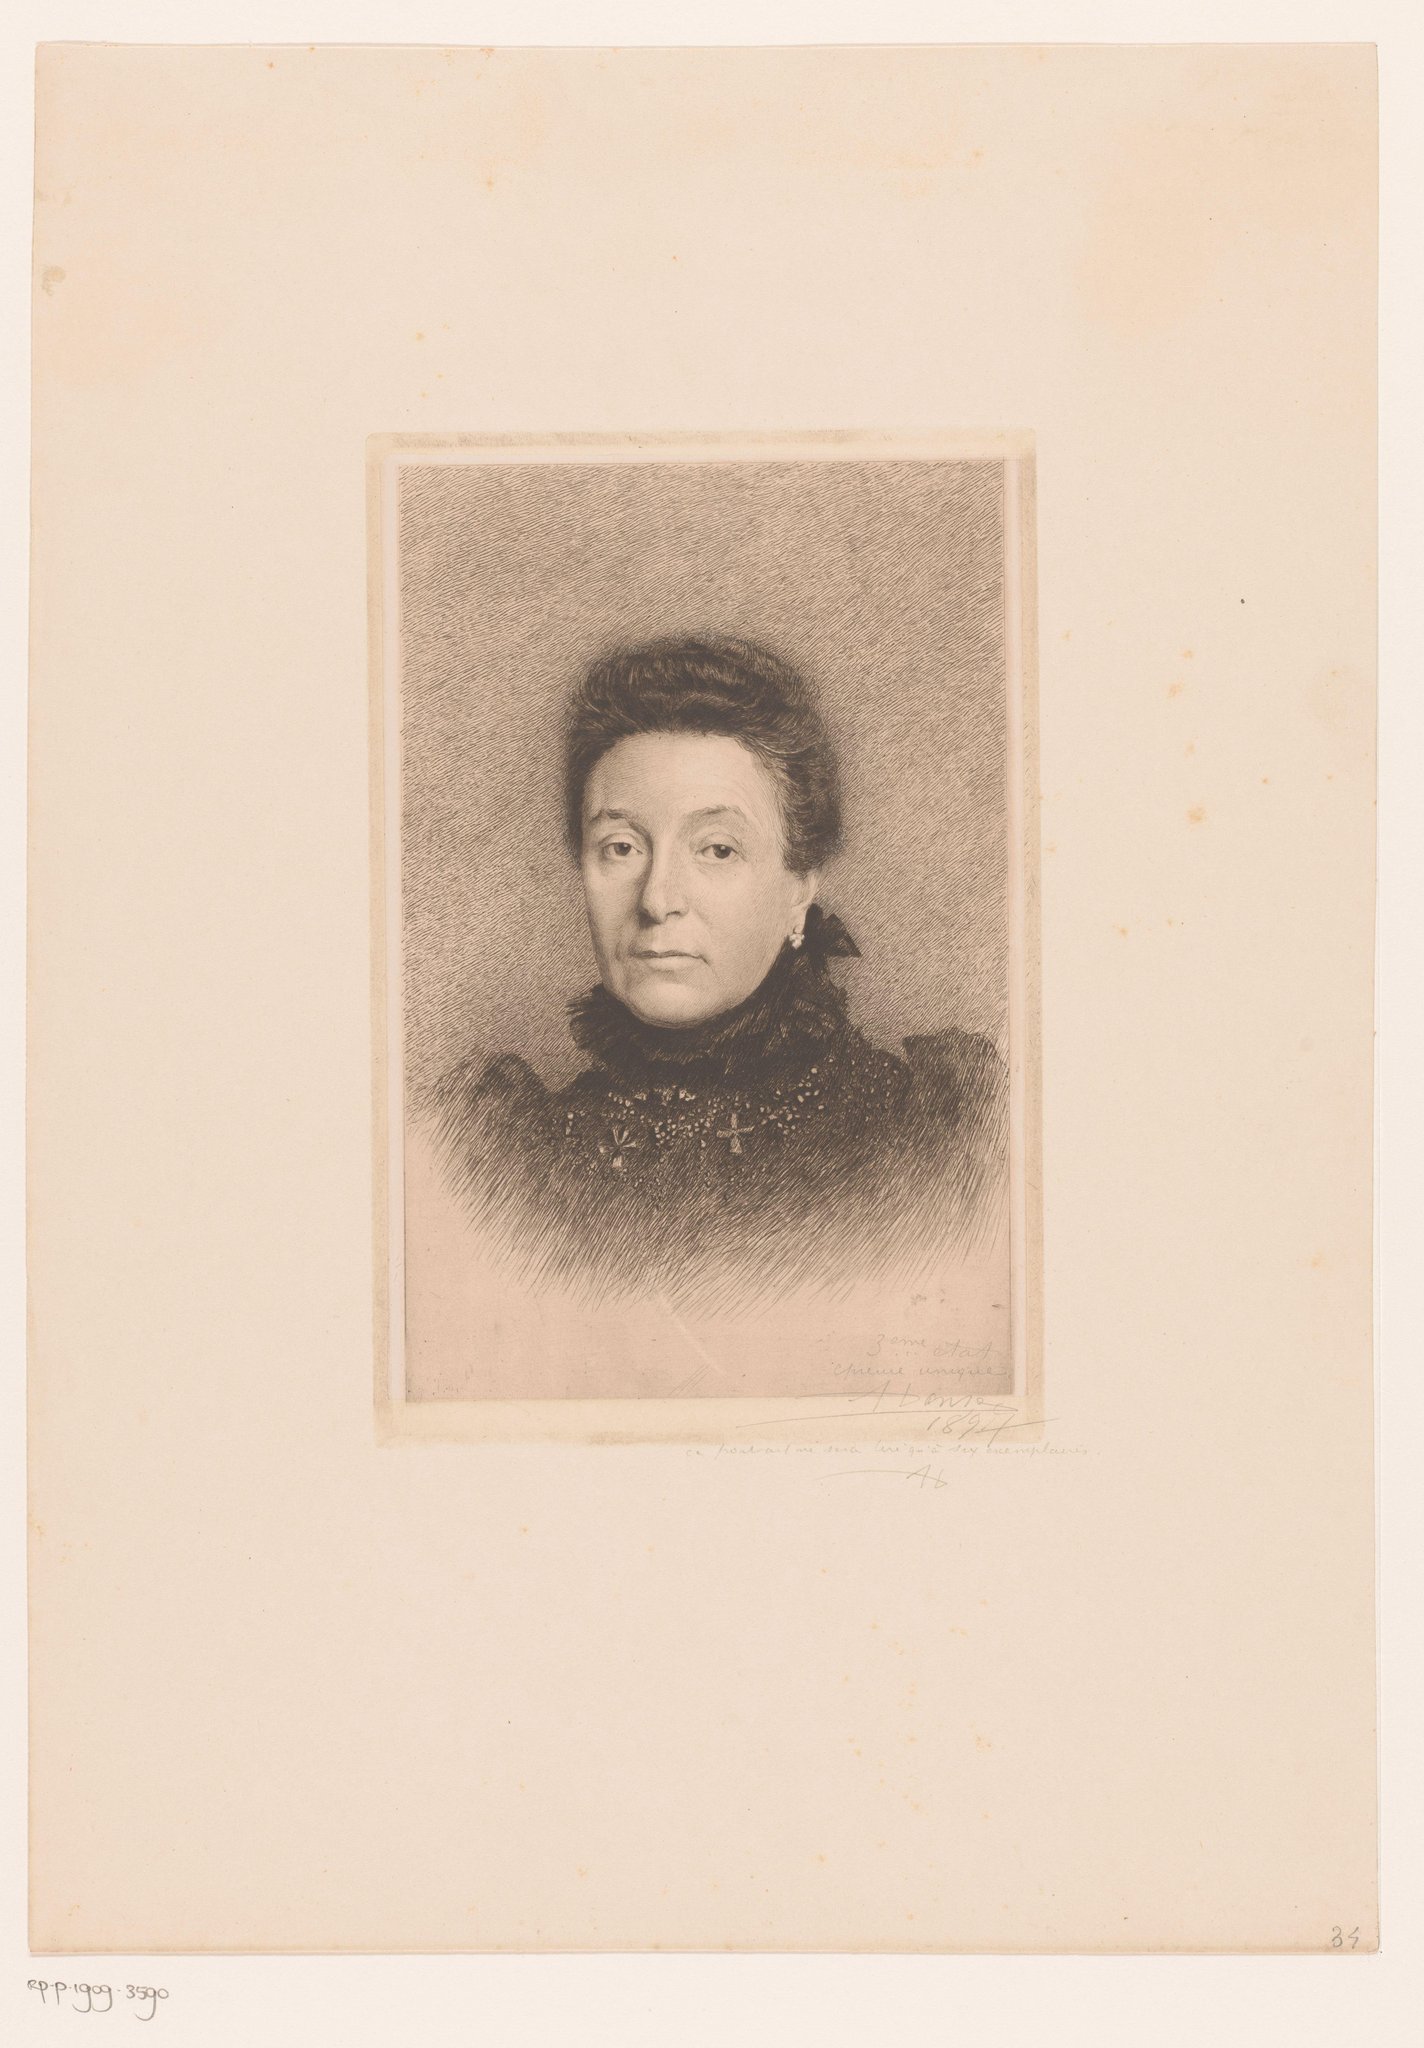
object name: print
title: Portret van de vrouw van Victor-Charles Mahillon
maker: auguste danse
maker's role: print maker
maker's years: 1829-1929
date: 1897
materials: paper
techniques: drypoint, etching, intaglio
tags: historical person (with name) - bb - woman - historical person (with name) portrayed alone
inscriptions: collector's mark: Lugt 2228, annotation: ‘3ème état; epreuve unique; ce portrait ne sera tiré qu'à six exemplaires’